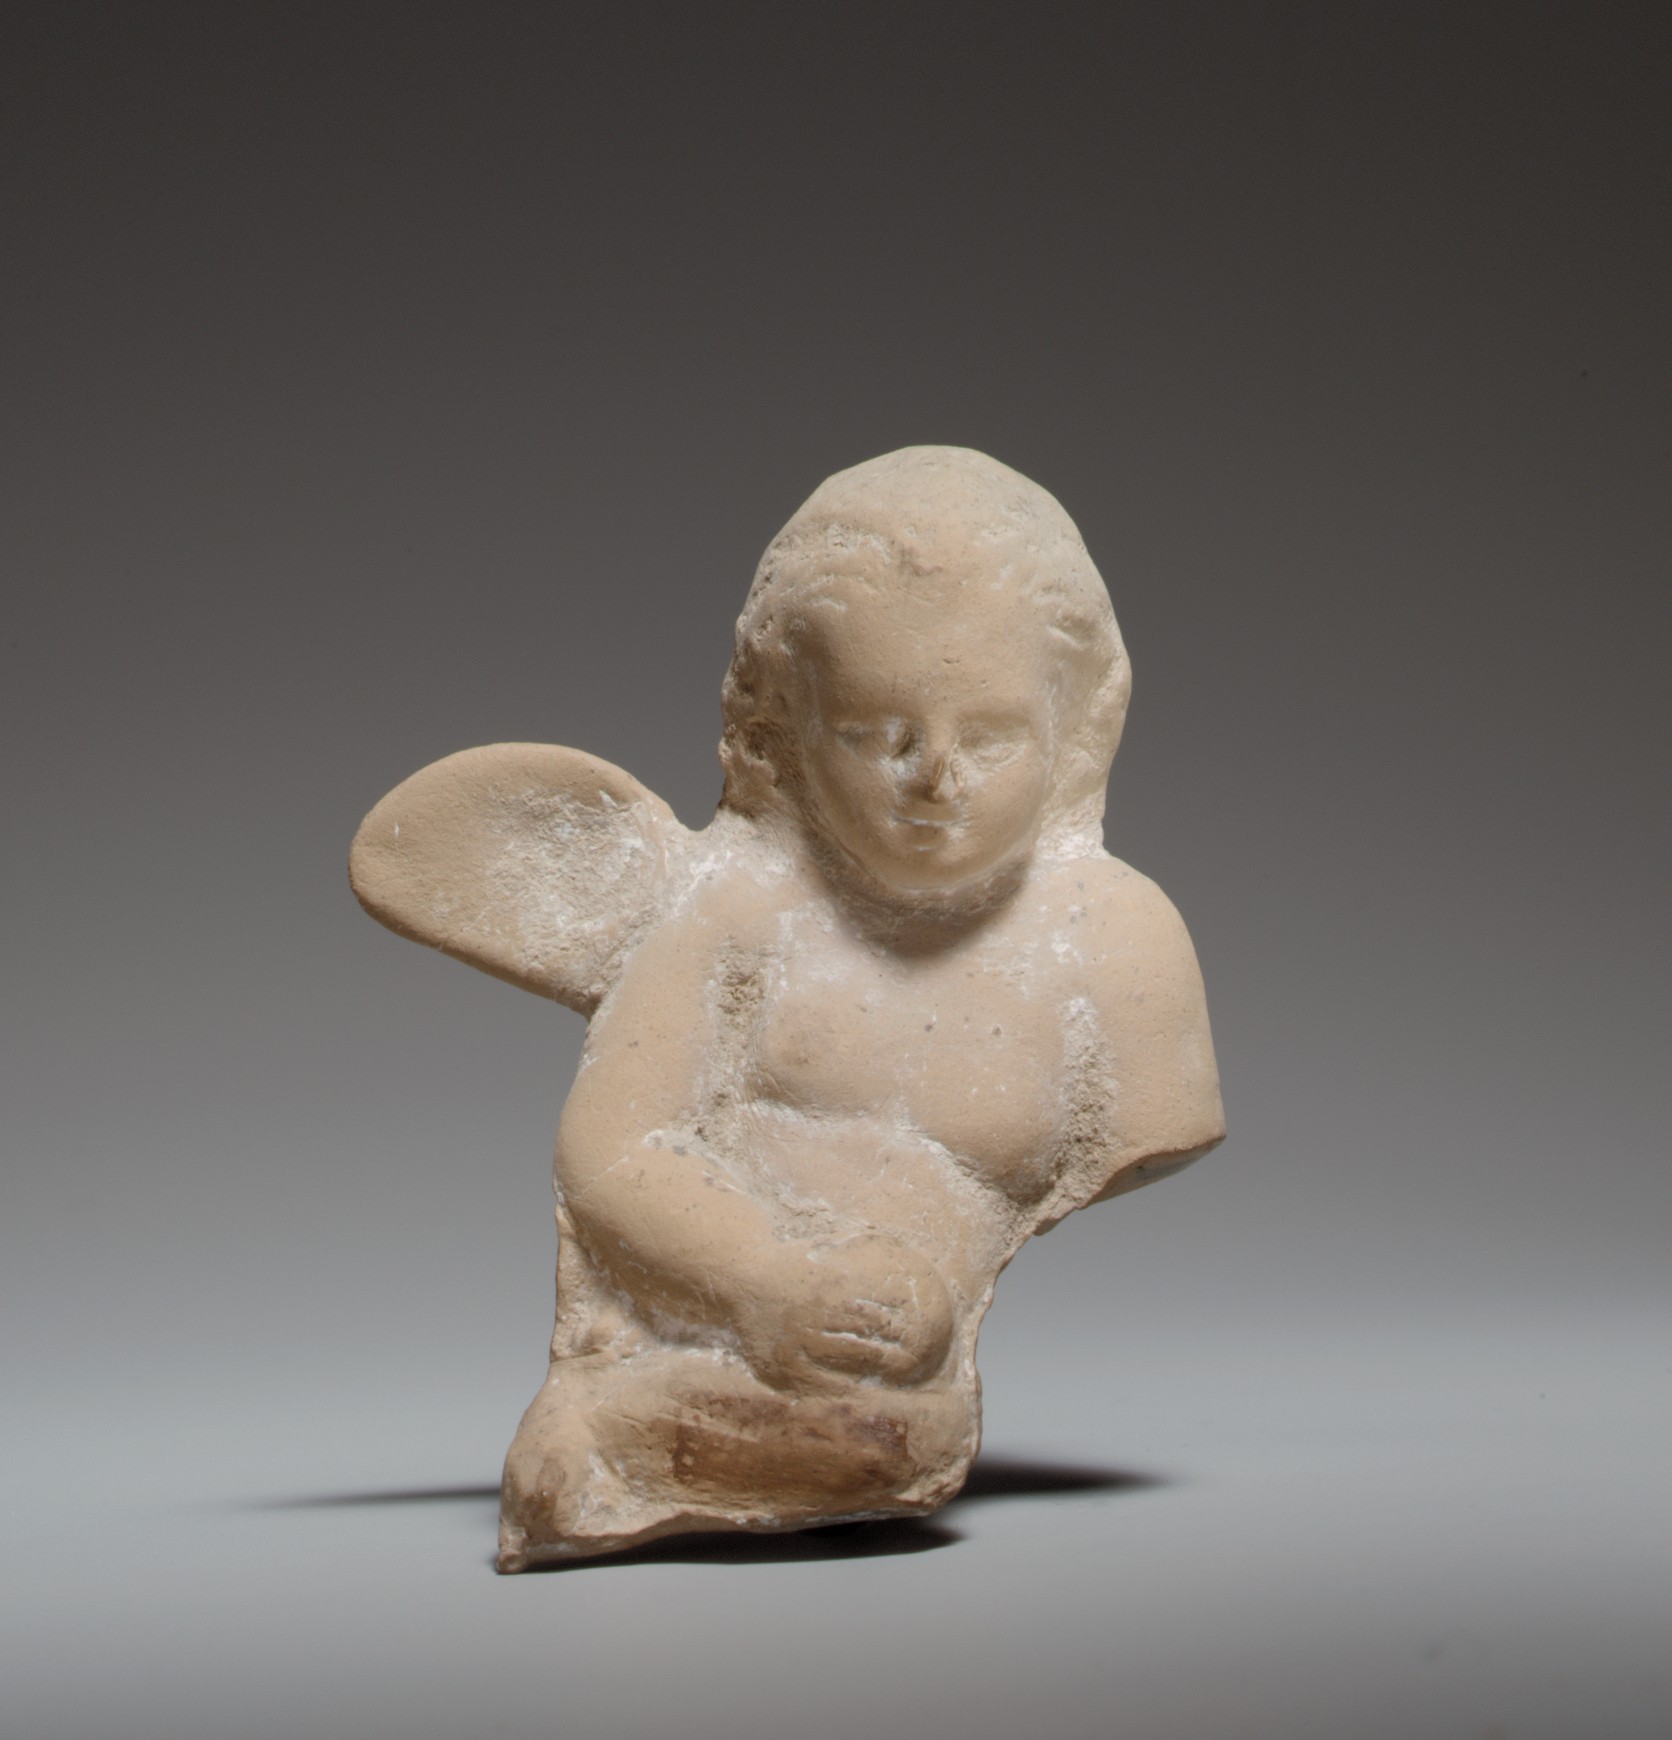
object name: statuette of eros holding an apple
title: Seated Eros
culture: cypriot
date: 300-201 BCE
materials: terracotta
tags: eros